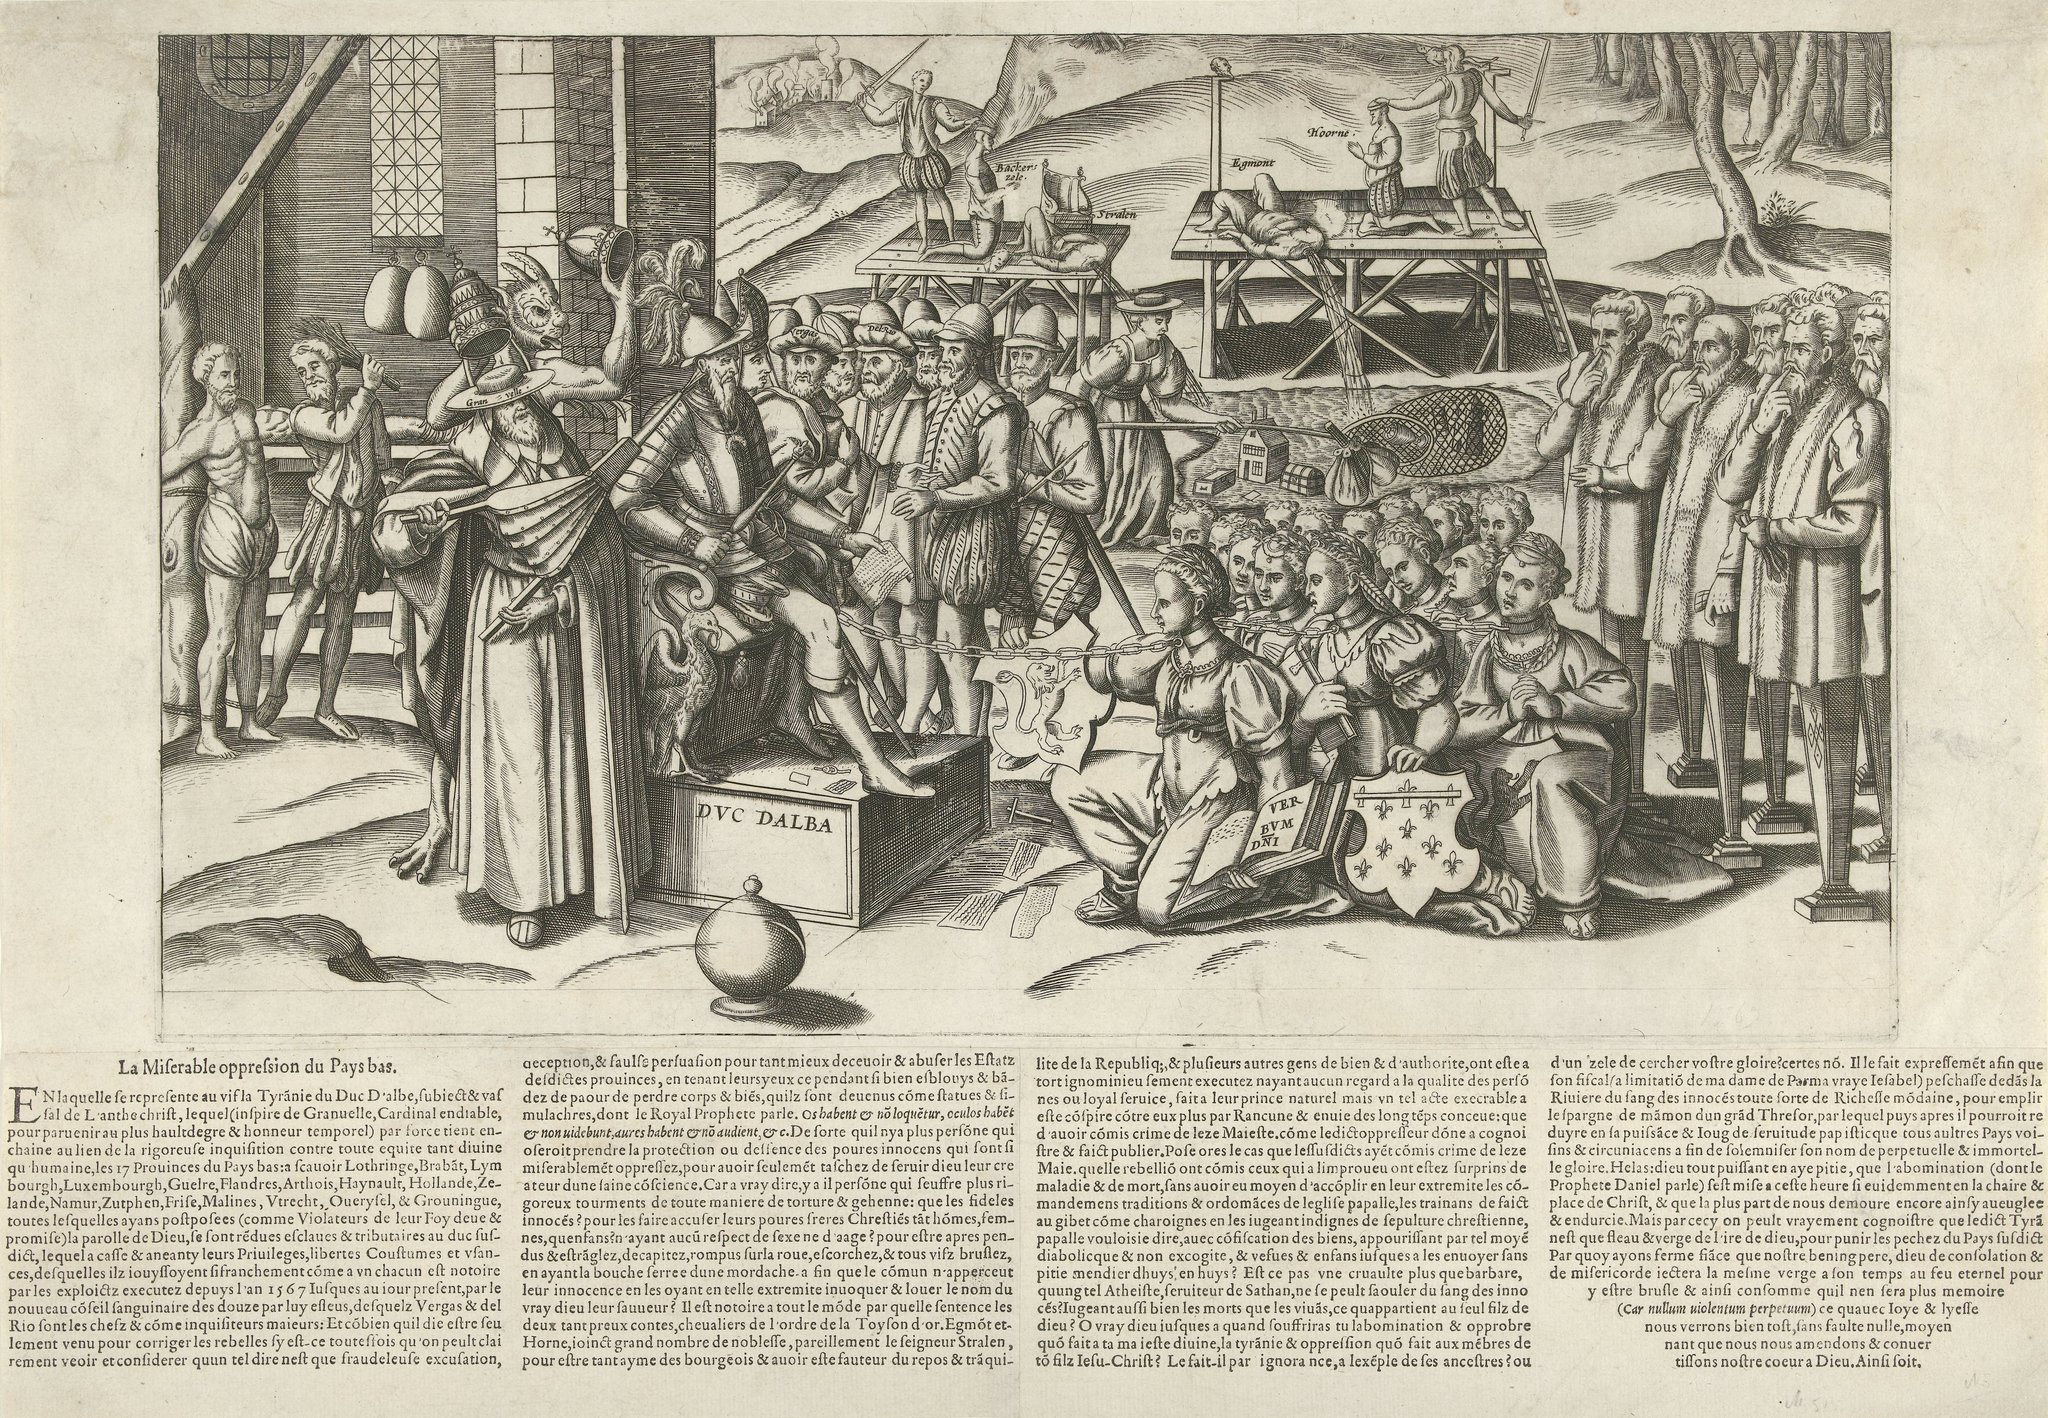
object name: print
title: The Tragic Oppression of the Netherlands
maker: Anonymous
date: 1569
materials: paper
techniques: engraving, letterpress printing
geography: southern netherlands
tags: fernando álvarez de toledo (3rd duke of alba), antoine perrenot de granvelle, bruges, violent death by beheading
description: Seventeen women in chains, one for every province, kneel before Alva on his throne. Surrounded by advisers and the devil he rips up agreements and treaties. At the right are the representatives of the provinces: the States General. All of them silenced. Nobles are beheaded or flagellated, and the pond fished out. There can be no doubt: Alva has brought nothing but misery and crushed the freedom of the Netherlands.